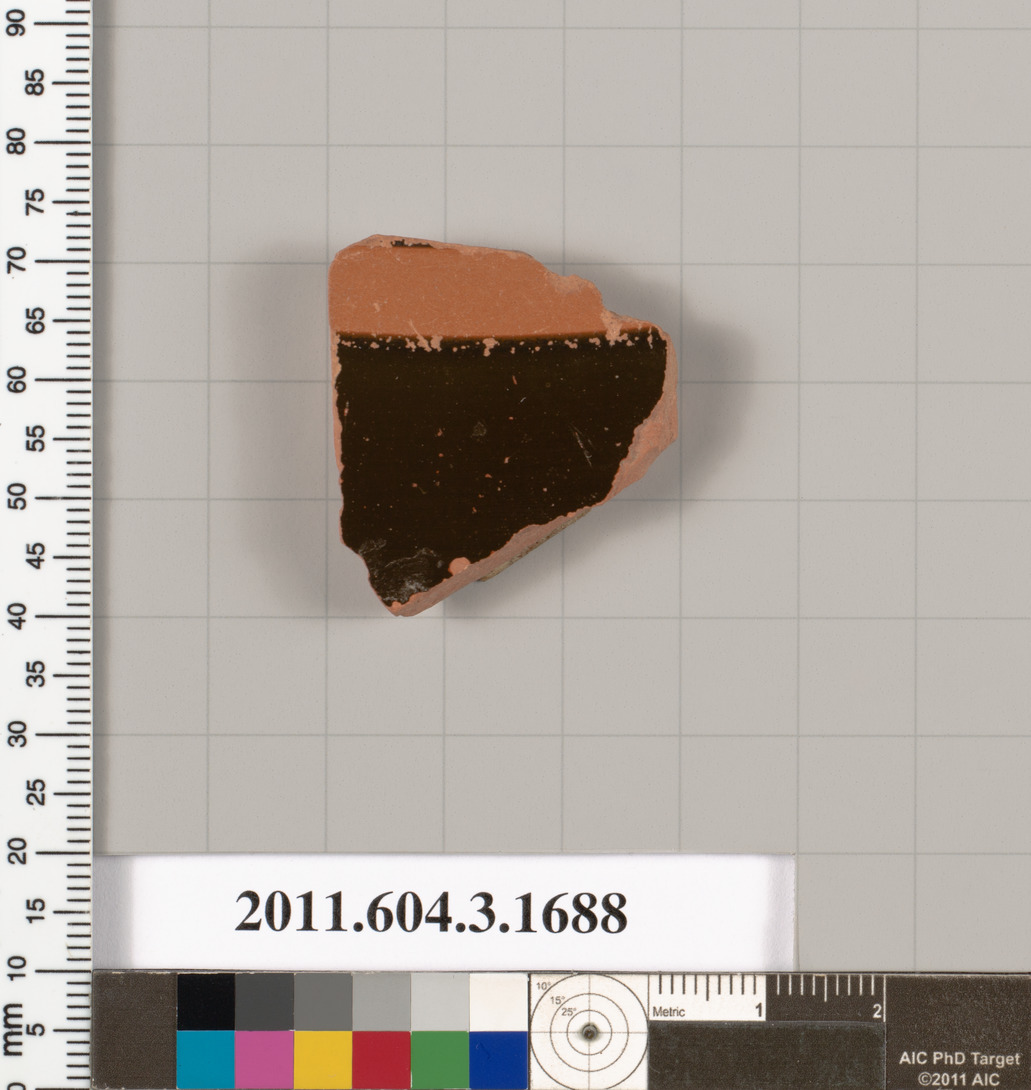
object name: kylix fragment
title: Terracotta fragment of a kylix: Band or lip cup (drinking cup)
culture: greek, attic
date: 550-526 BCE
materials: terracotta